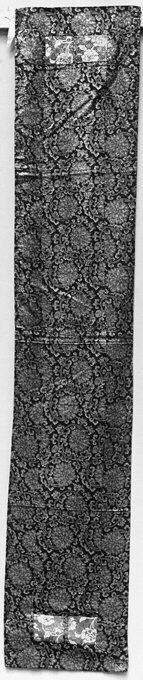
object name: stole, priest's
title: Priest's Stole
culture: japanese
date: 1550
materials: metal thread, silk